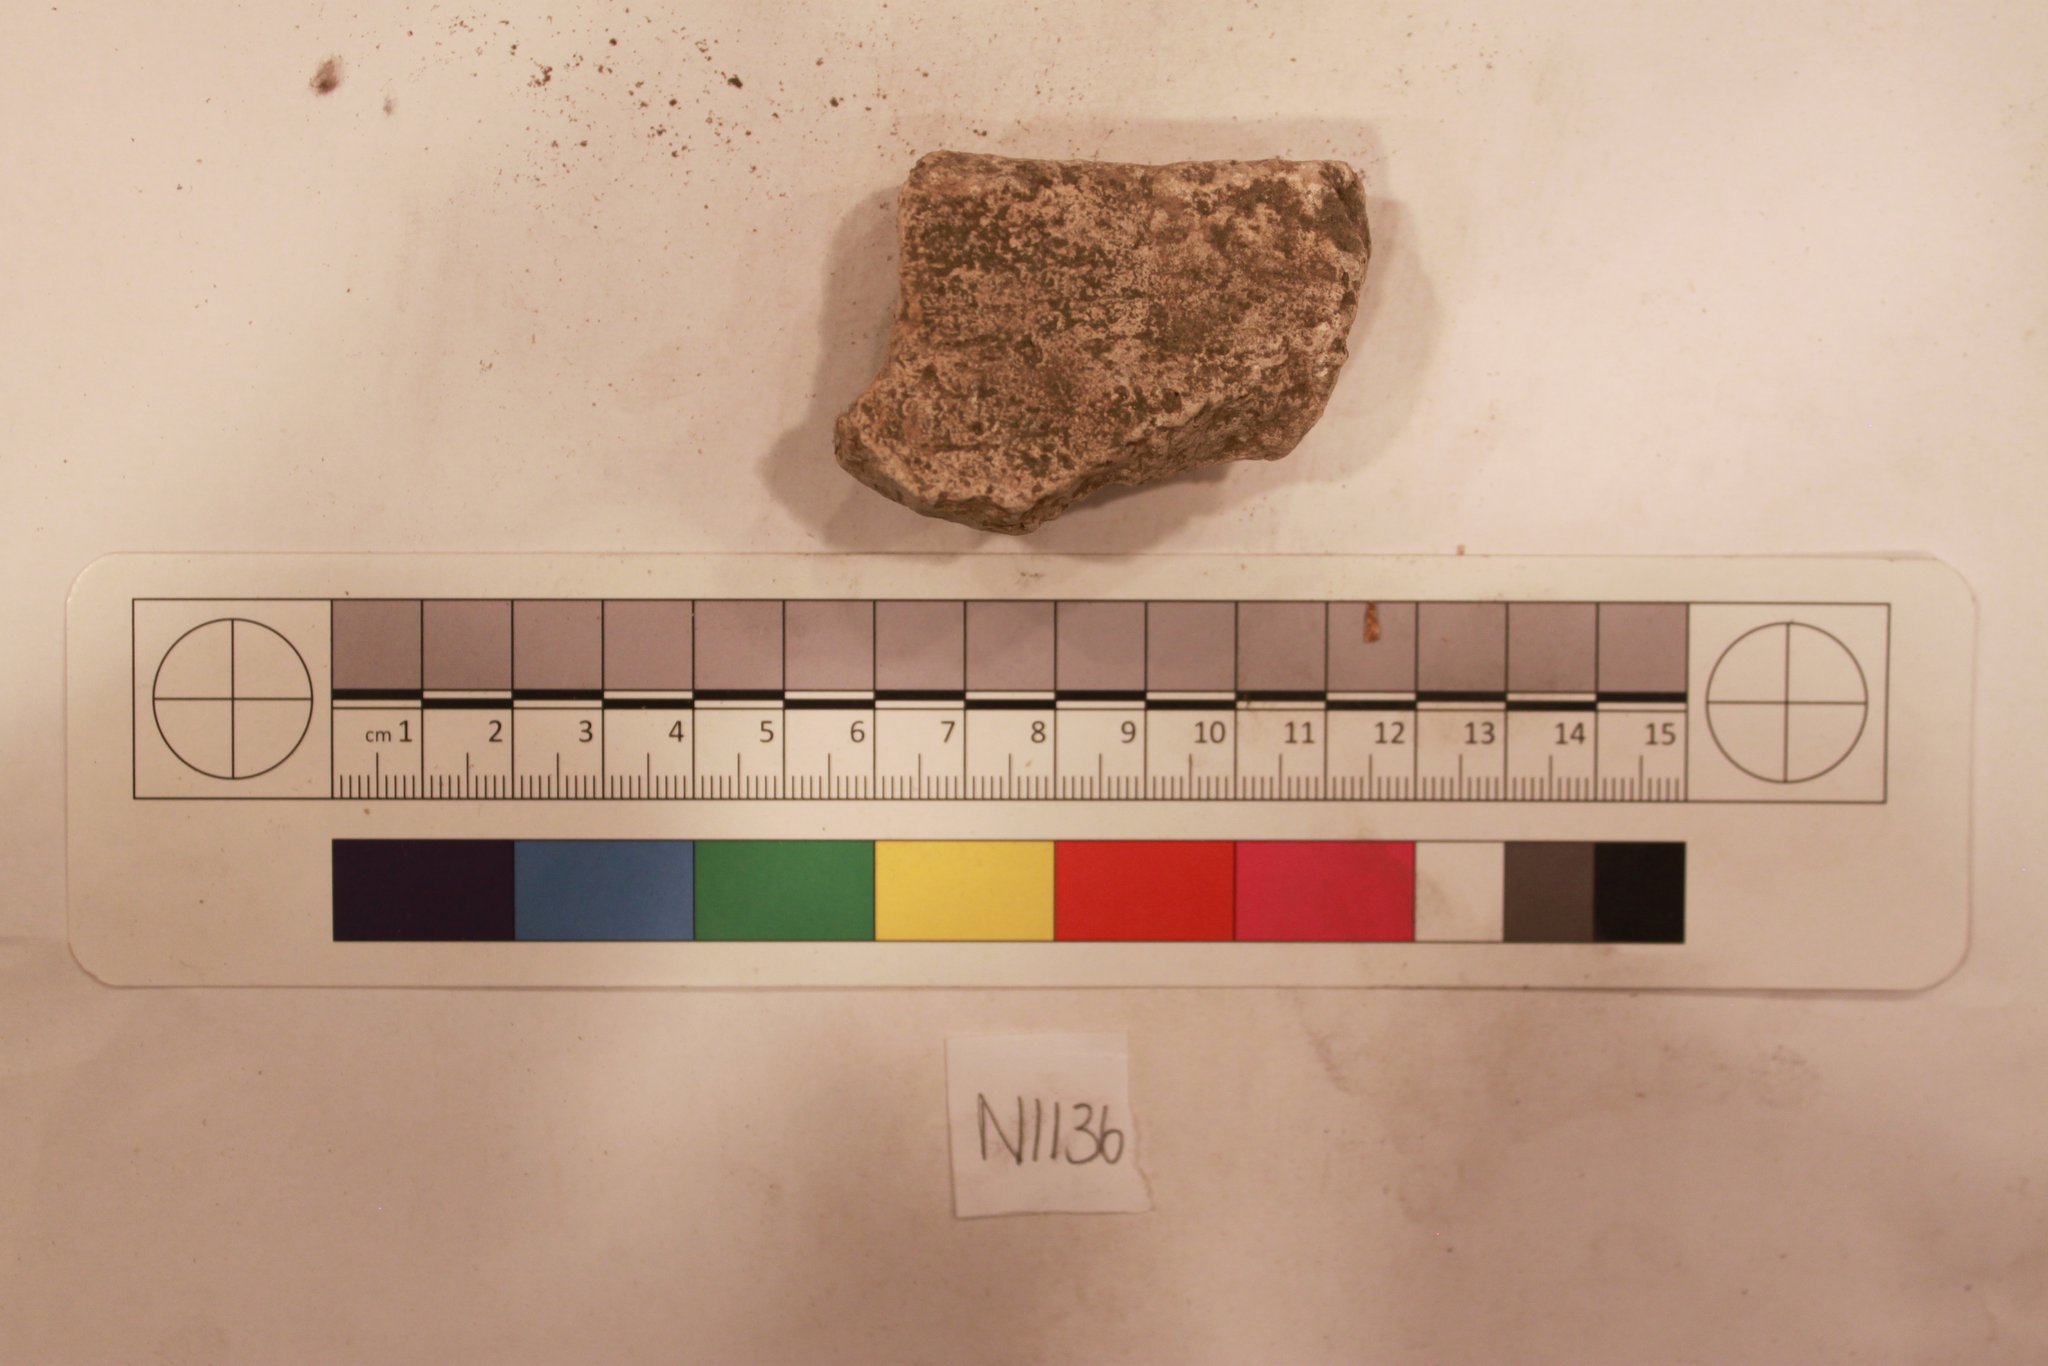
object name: fragment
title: Stucco Fragment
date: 701-1200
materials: plaster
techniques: carving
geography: iran